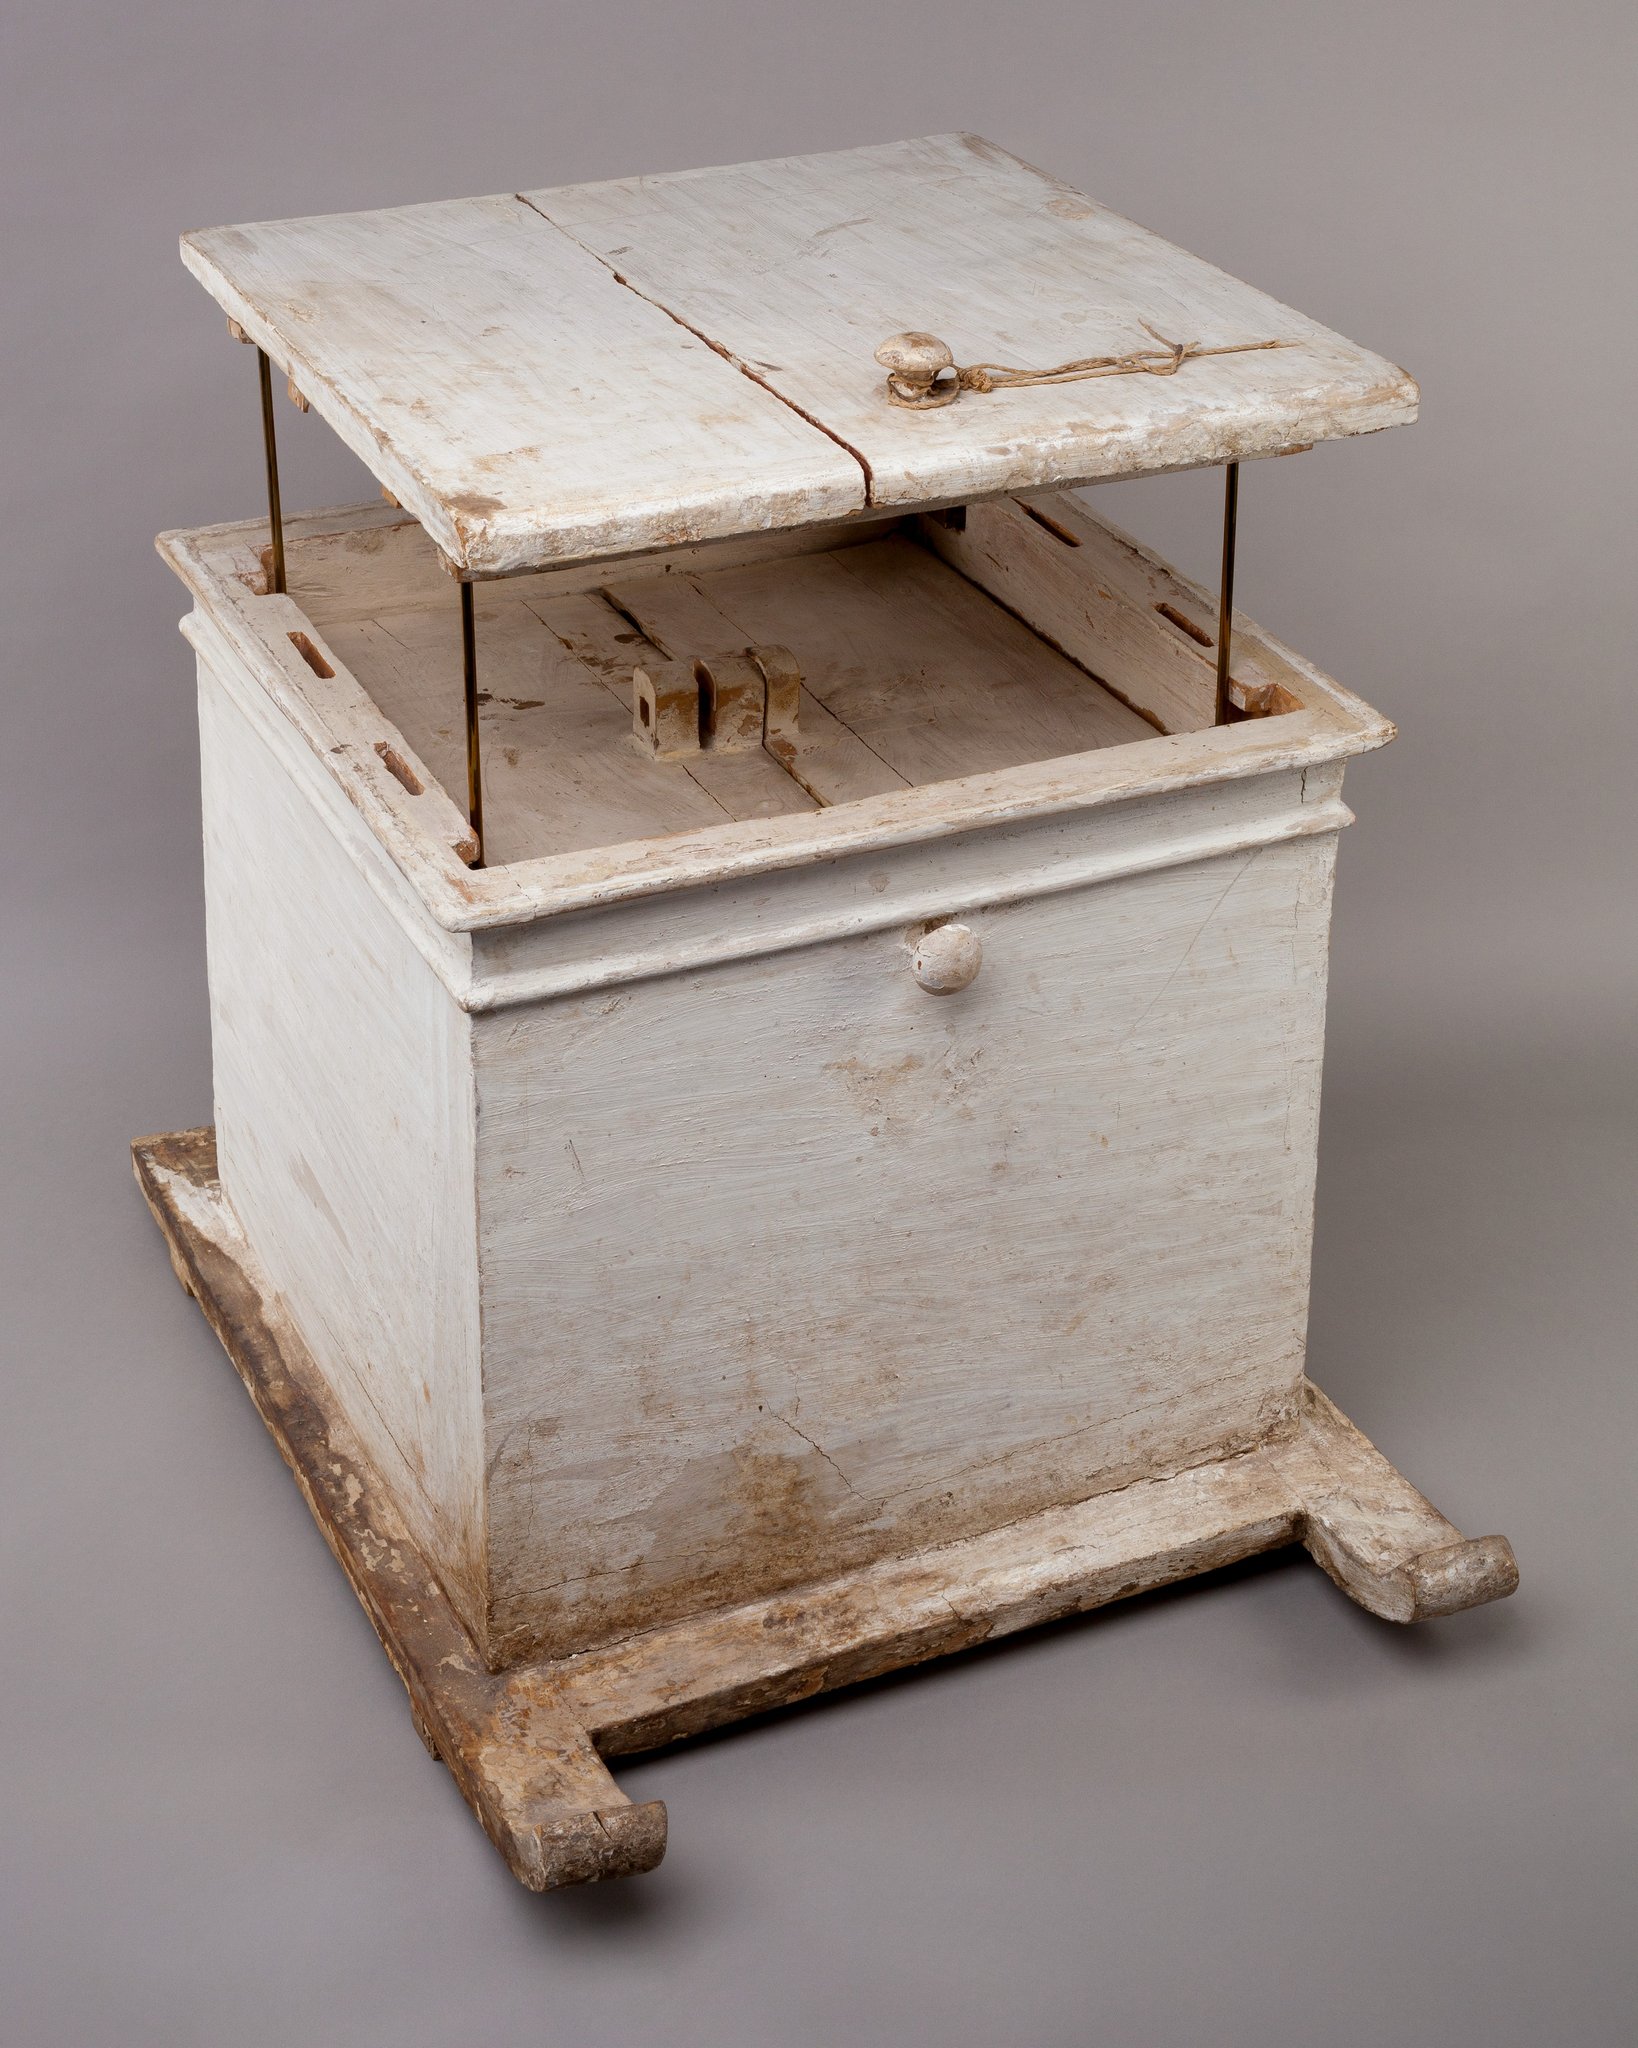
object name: canopic chest, hatnefer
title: Canopic box of Hatnefer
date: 1492-1473 BCE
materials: gesso, linen, wood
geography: egypt